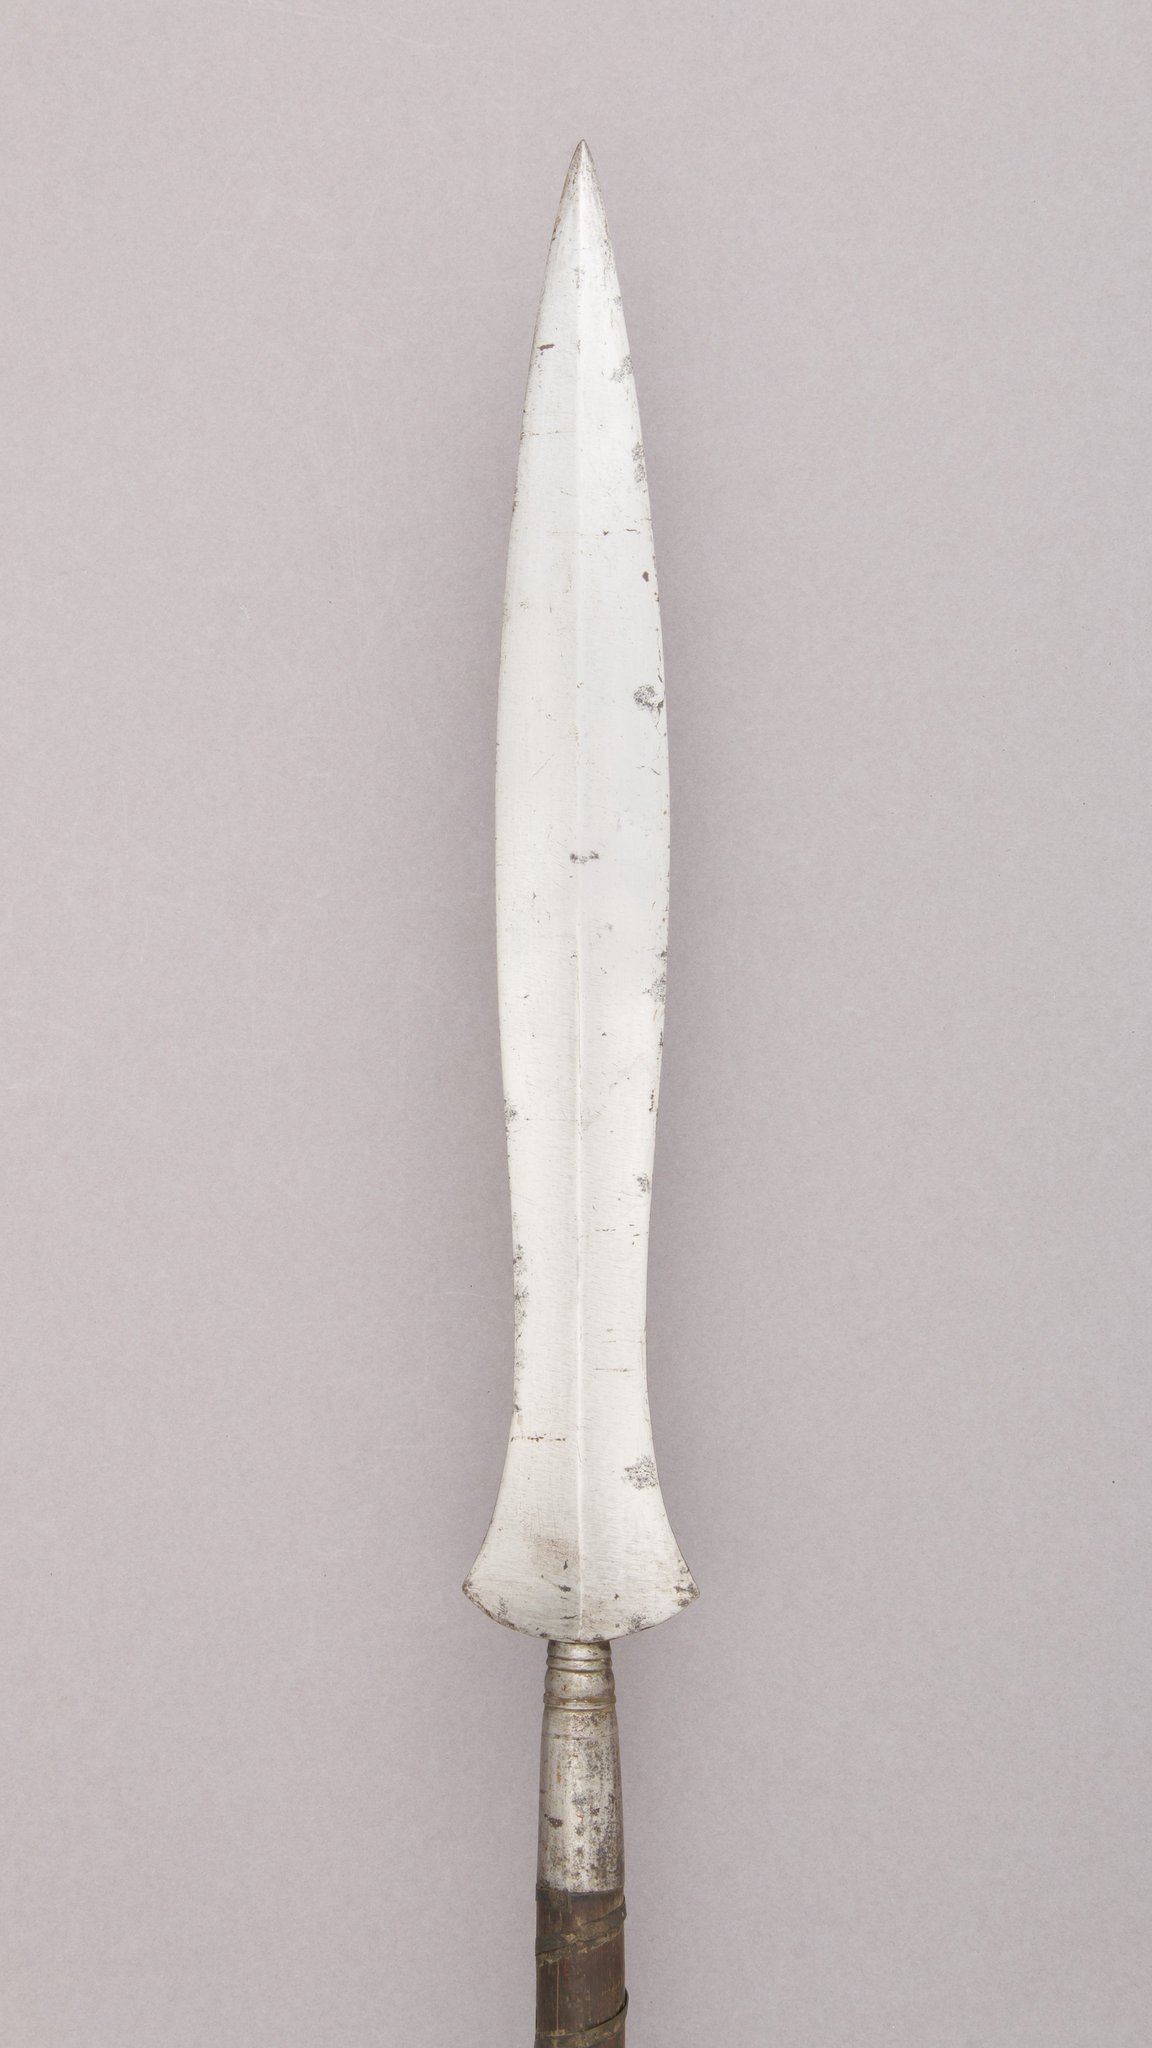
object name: spear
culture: javanese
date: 1501-1900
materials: silver, steel, wood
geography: indonesia